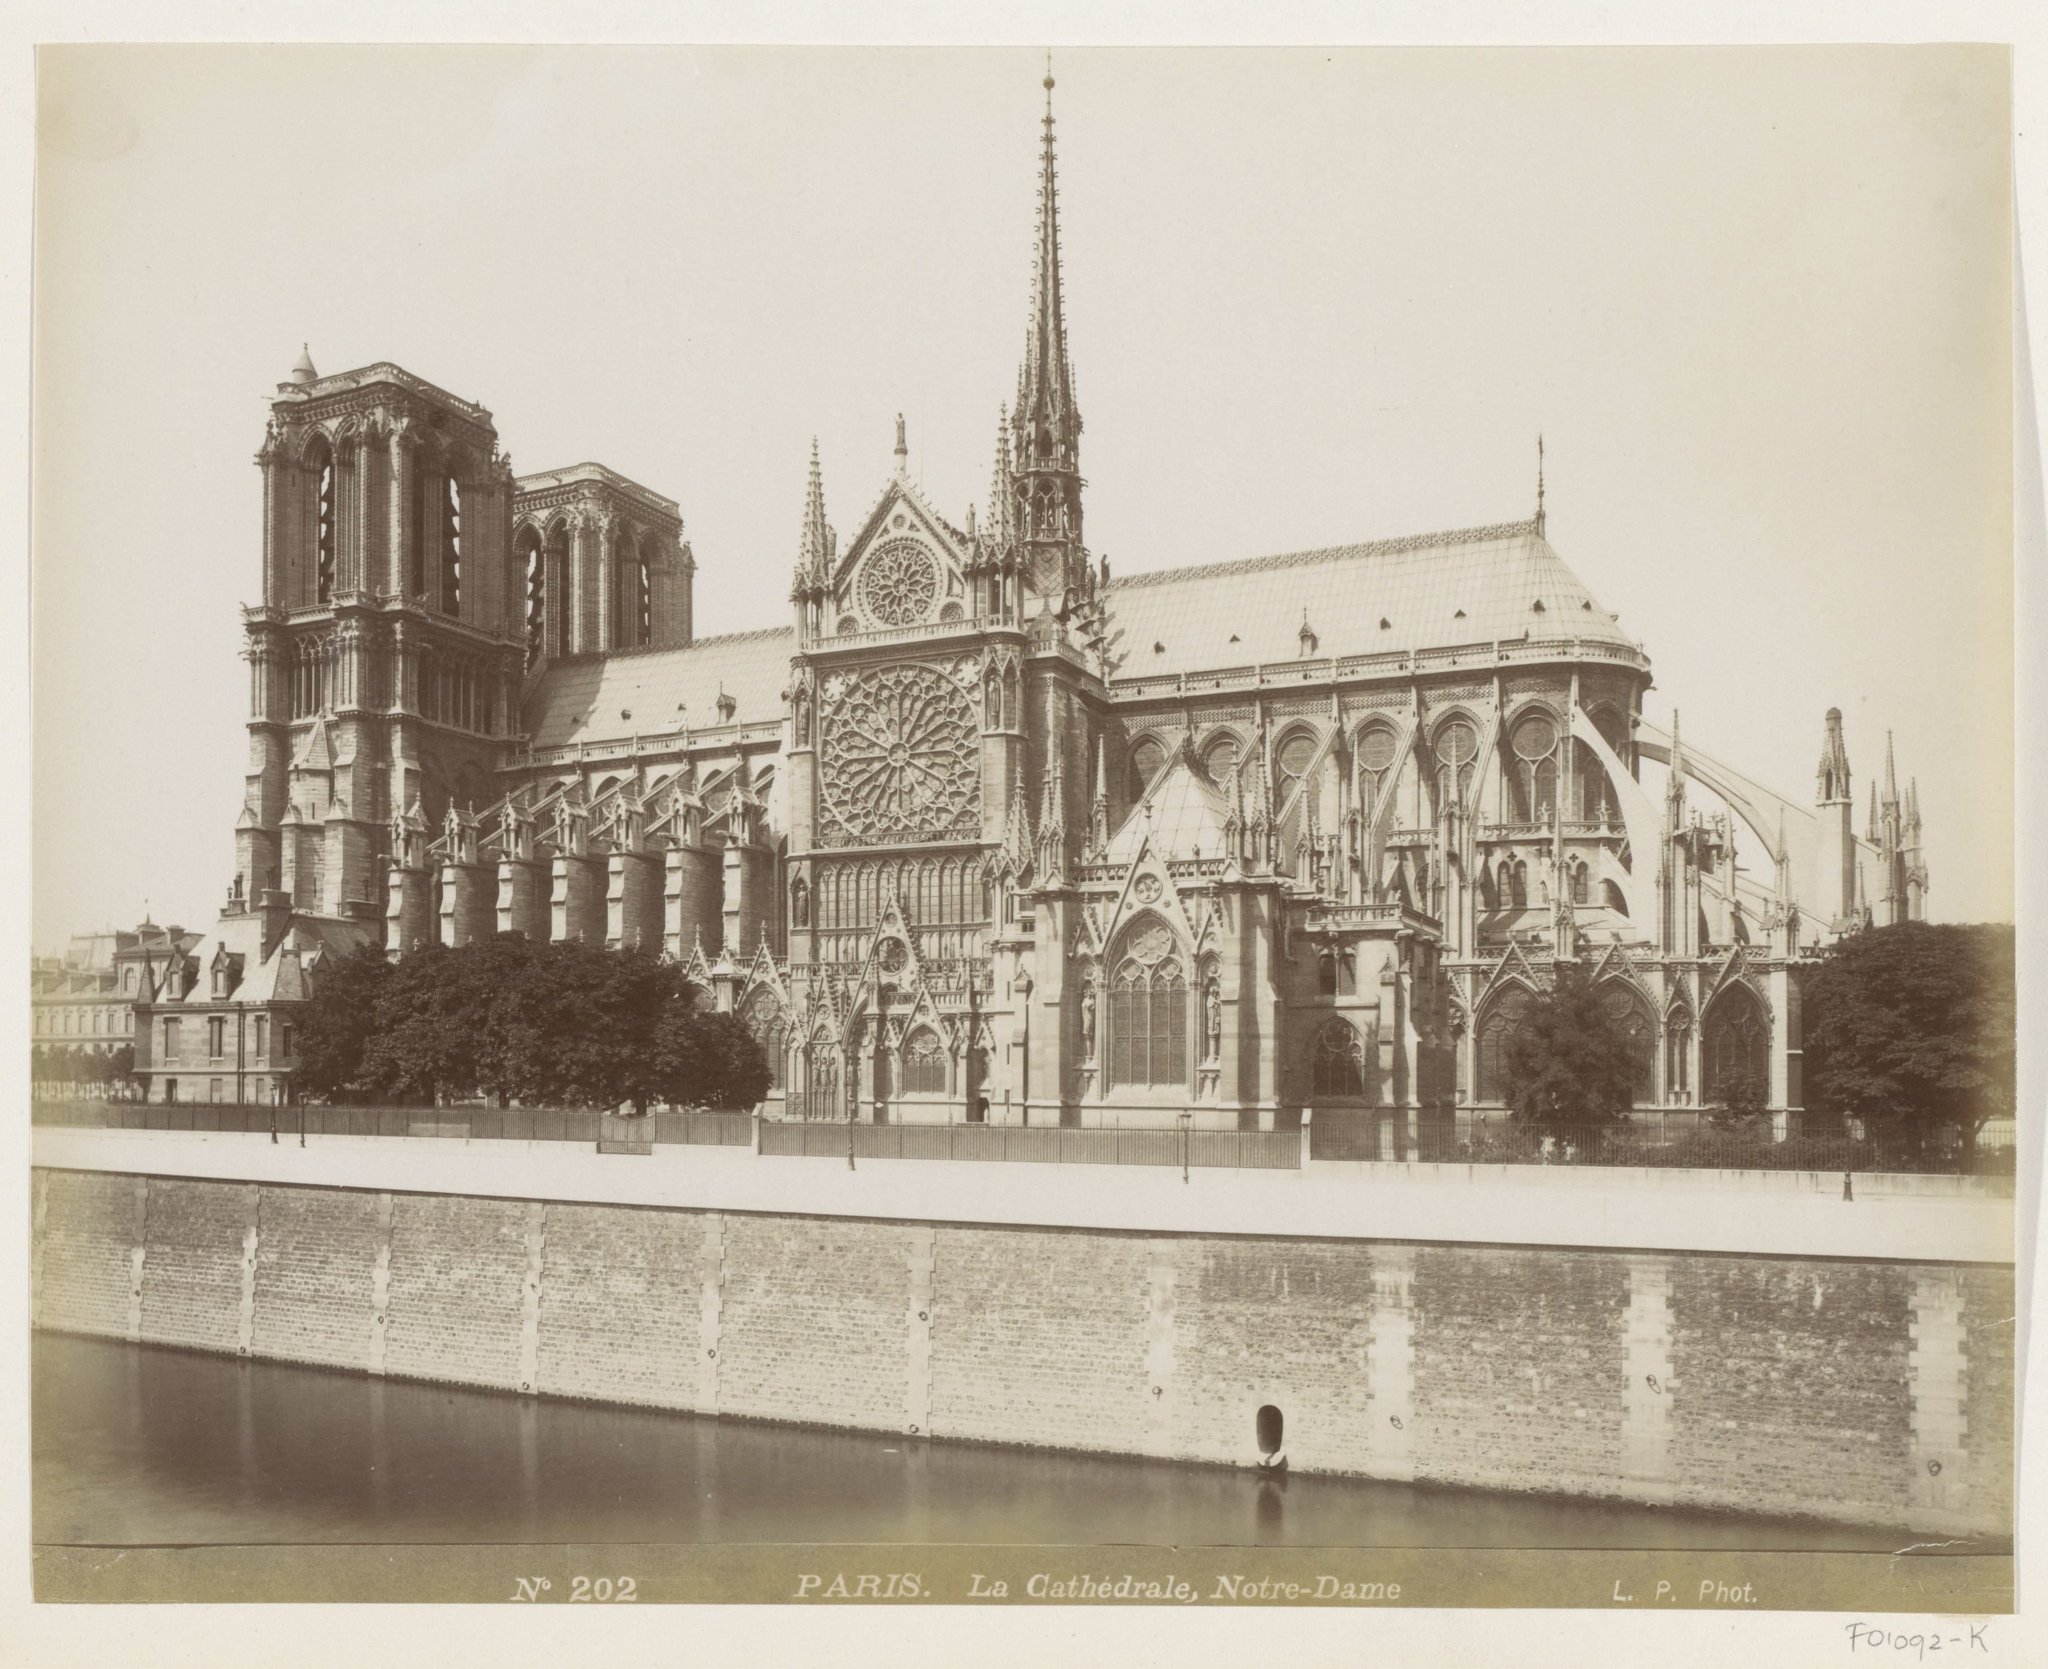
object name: photograph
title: West- en zuidgevel van Cathédrale Notre-Dame in Parijs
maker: louis antoine pamard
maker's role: fotograaf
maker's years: 1840-1893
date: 1880-1900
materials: cardboard, paper, photographic support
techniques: albumen print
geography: paris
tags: church (exterior), parts of church exterior and annexes: tower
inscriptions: negative number: ‘202’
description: Onderdeel van Reisalbum met foto's van bezienswaardigheden in België en Frankrijk.